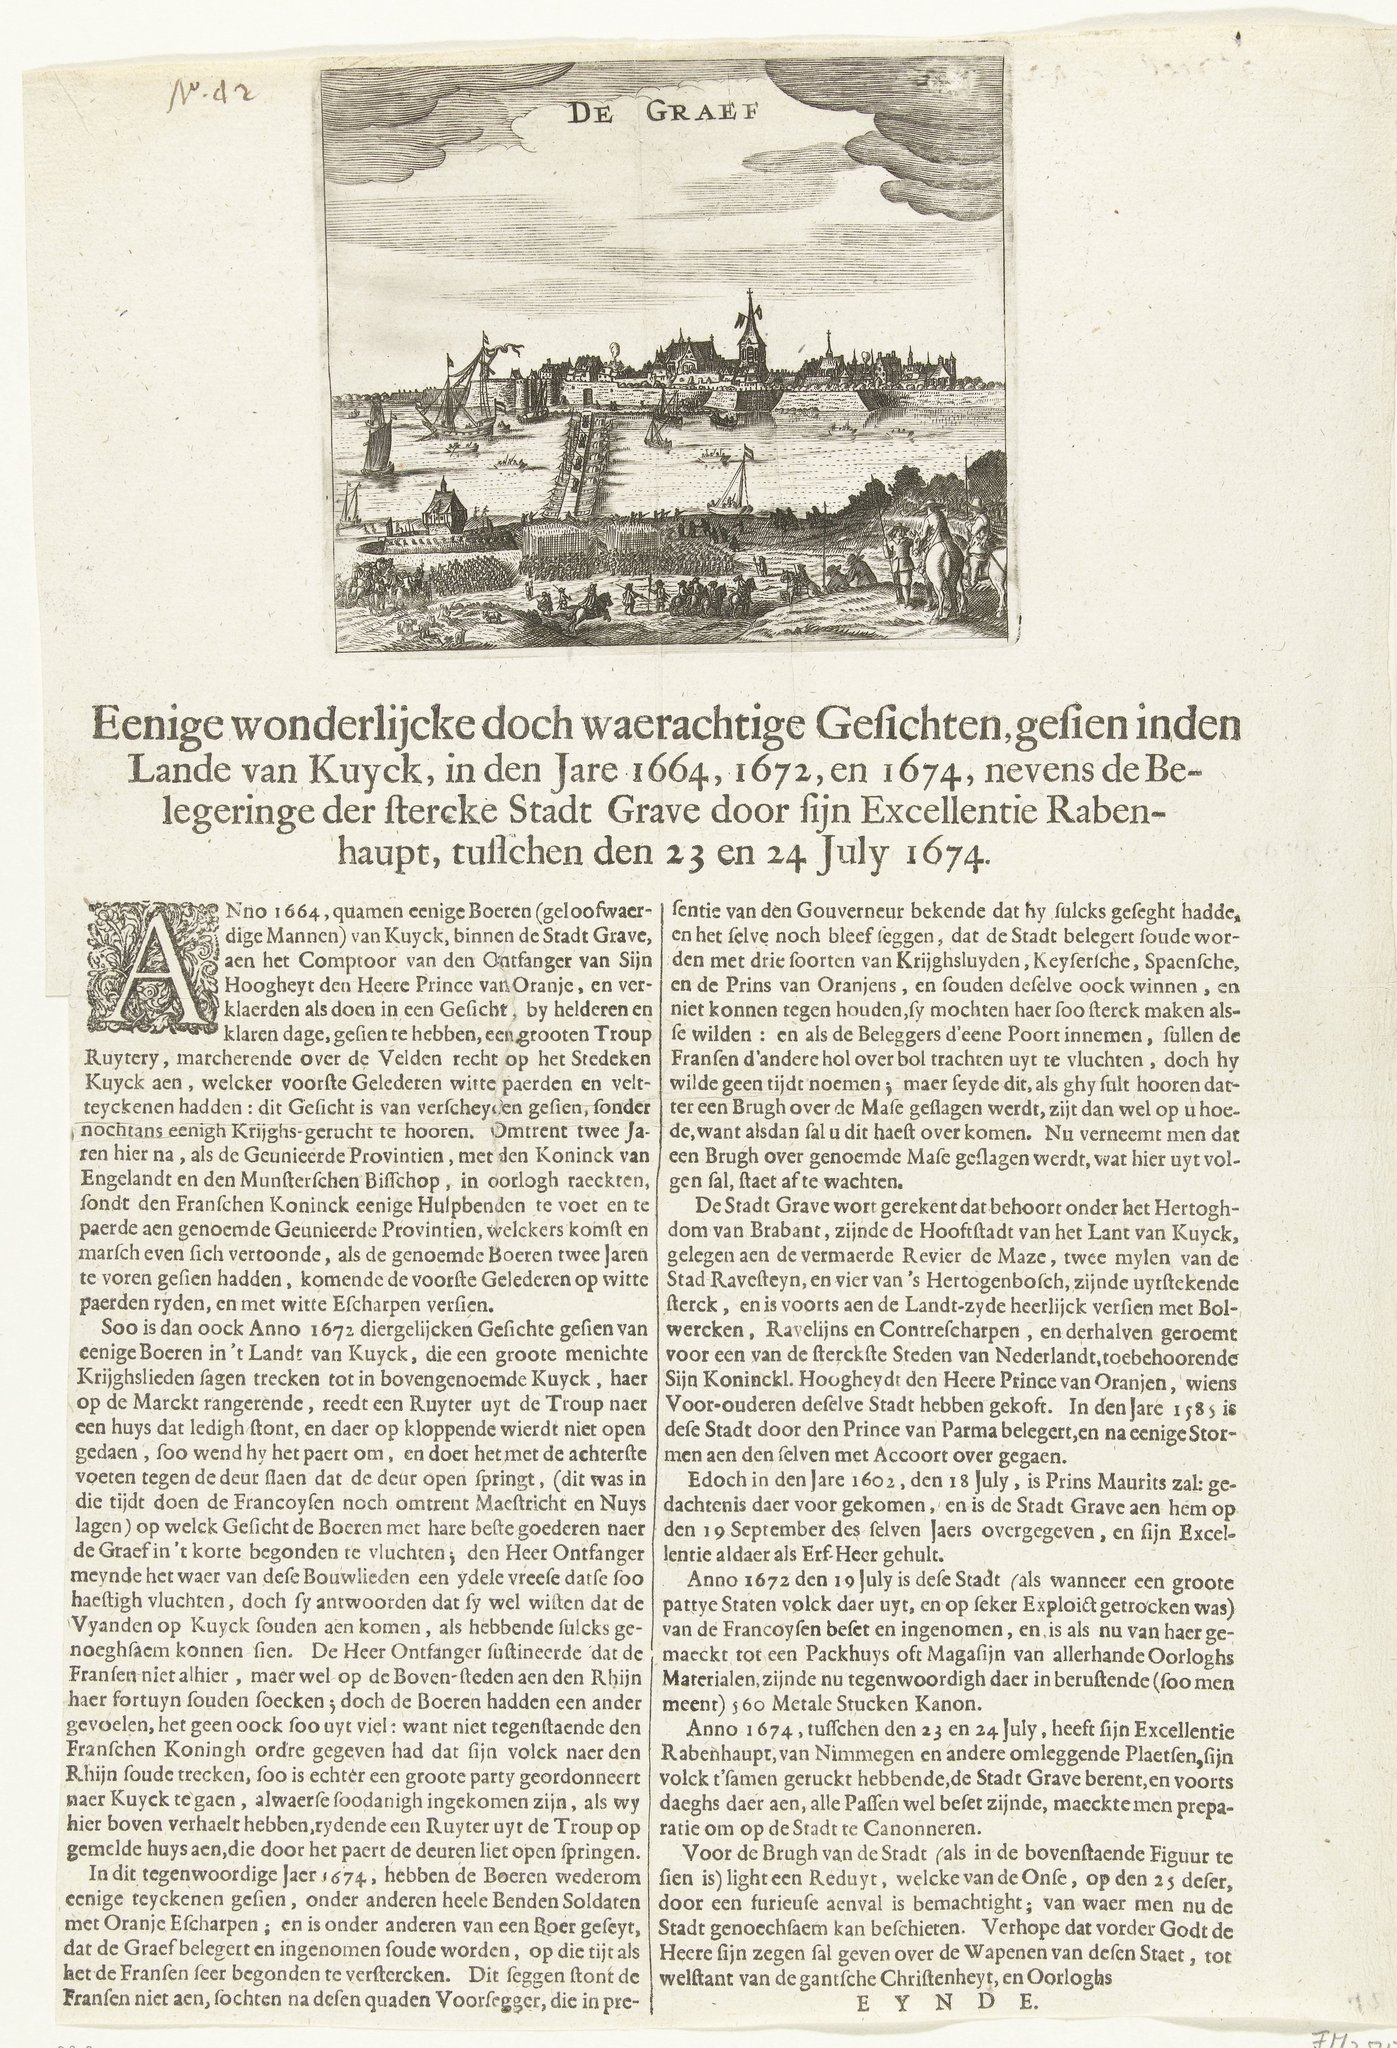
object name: print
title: Beleg van Grave, 1674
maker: Anonymous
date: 1674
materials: paper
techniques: engraving, letterpress printing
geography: northern netherlands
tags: siege, position war, grave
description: Beleg van Grave door een Staatse leger onder Rabenhaupt, 23-24 juli 1674. Gezicht op de stad met soldaten gelegerd aan de tegenoverliggende oever, met een schipbrug over de Maas.